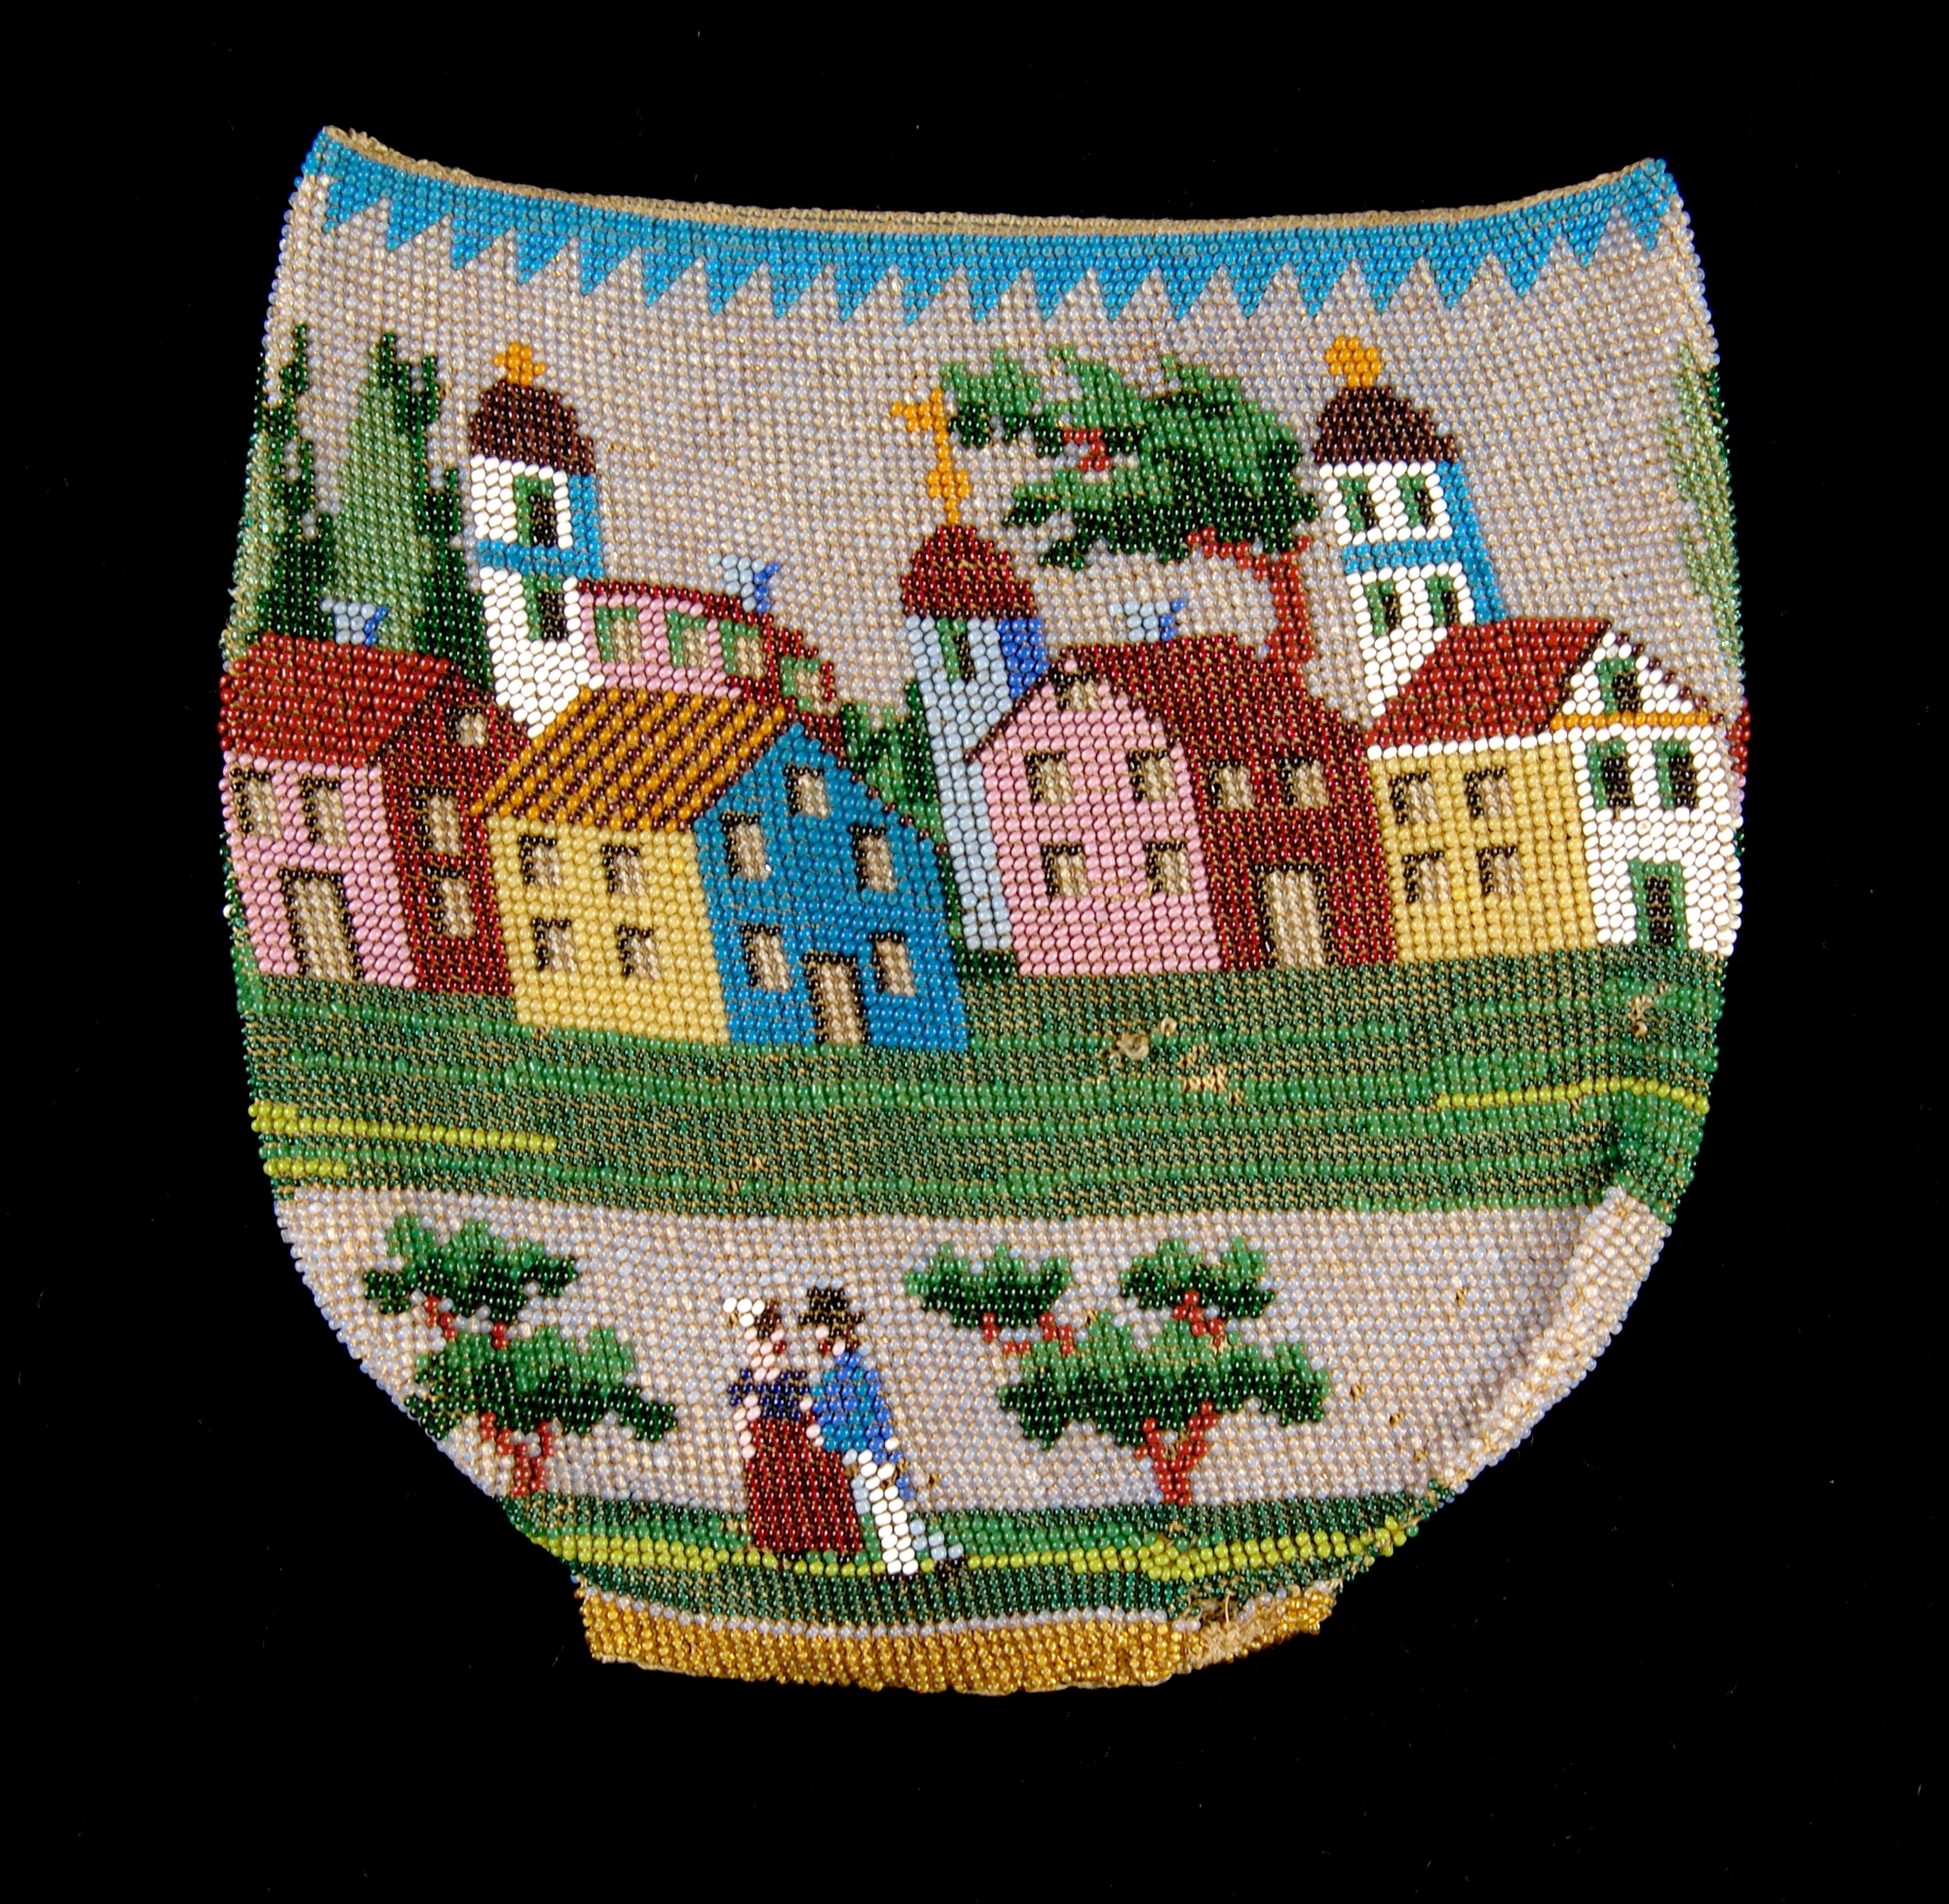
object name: pouch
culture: american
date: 1830-1860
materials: glass, linen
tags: houses,couples